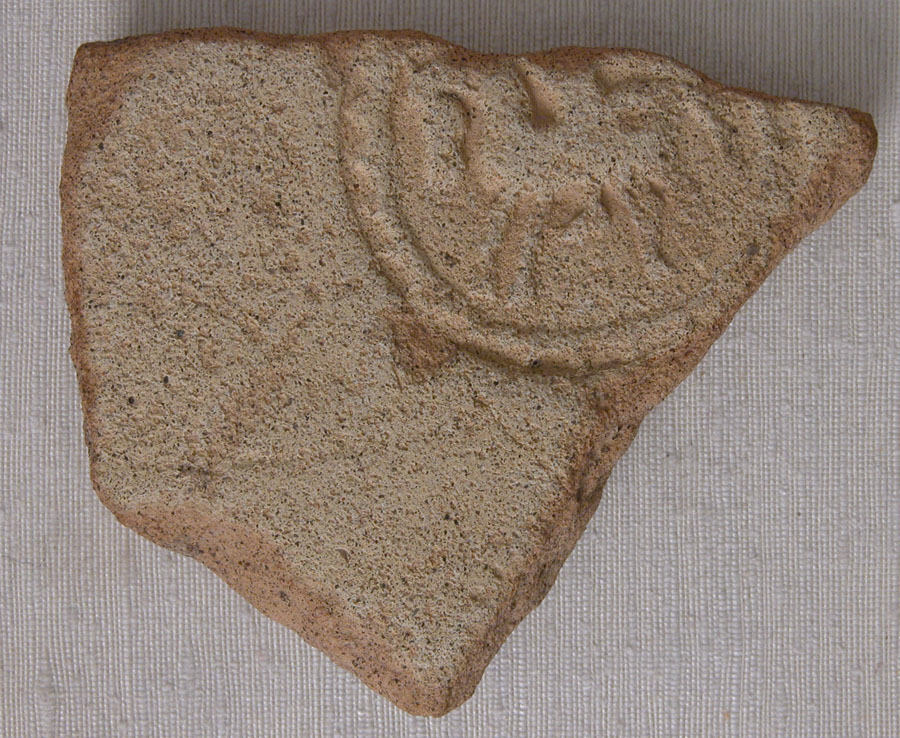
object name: fragment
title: Fragment of Vessel Stamped with a Medallion Displaying a Horse and Rider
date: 801-900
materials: earthenware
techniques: molding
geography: iraq